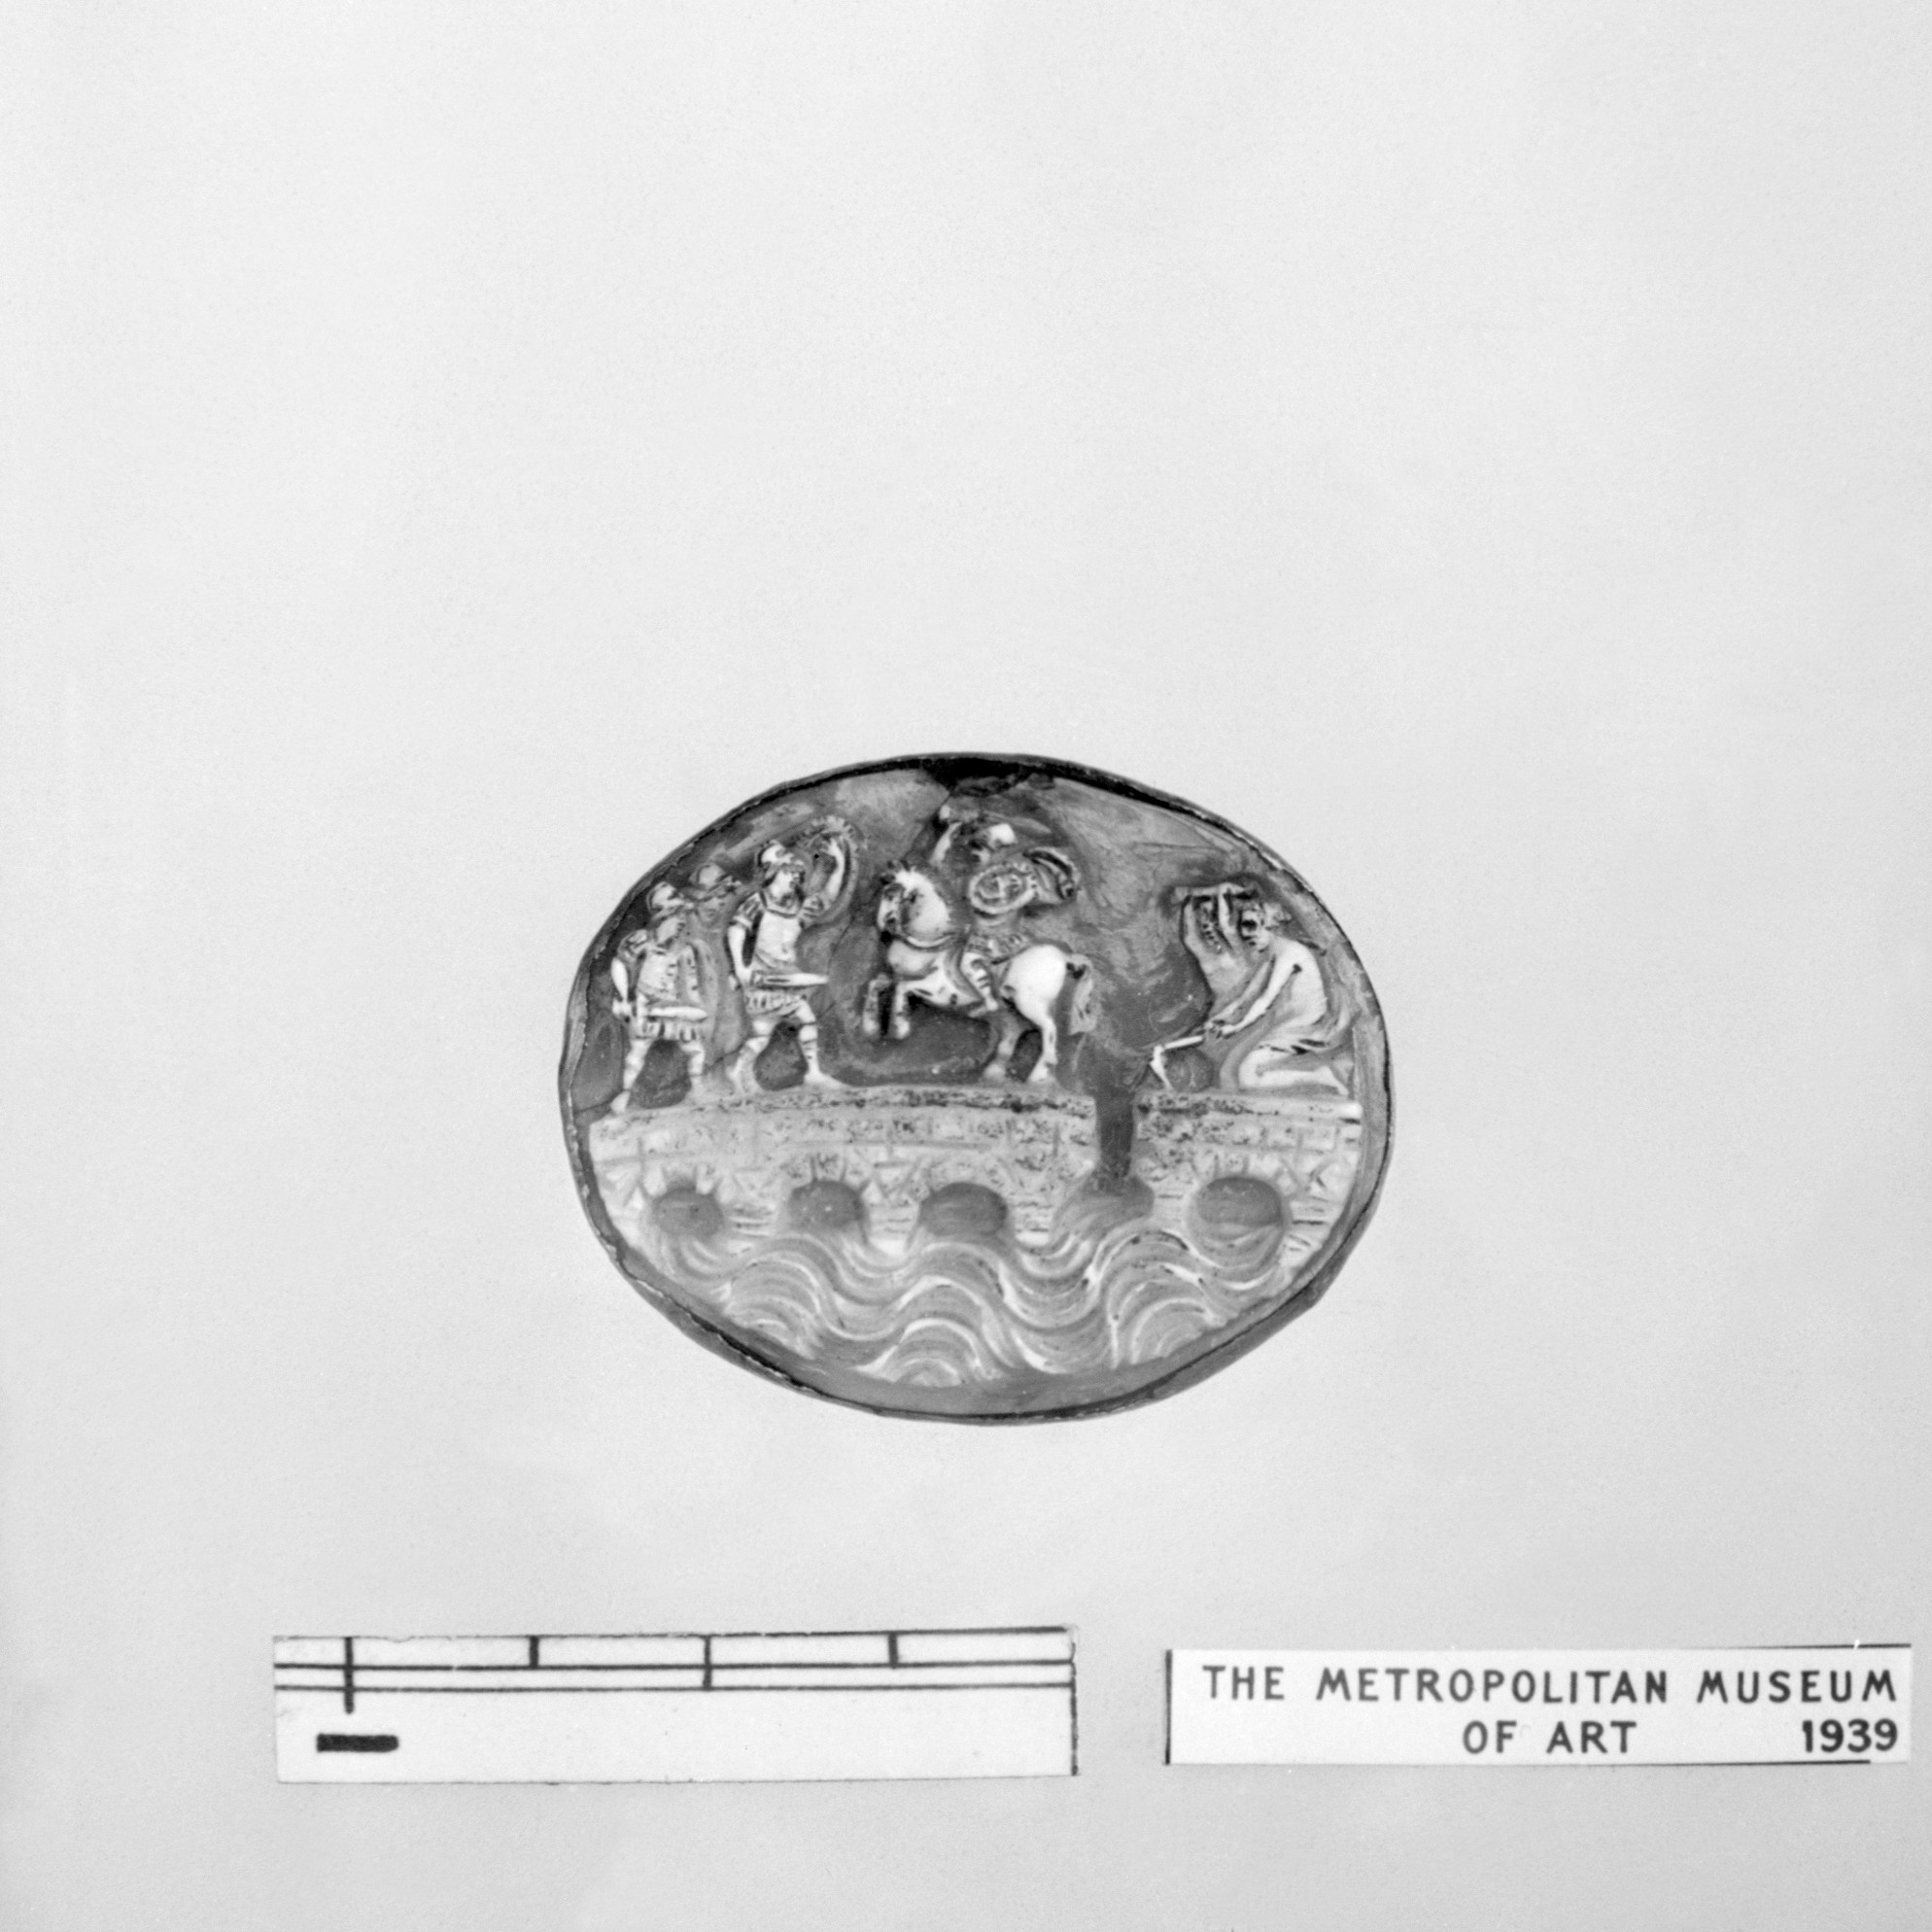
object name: cameo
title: Horatius at the Bridge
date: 1567-1600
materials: gold, onyx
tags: men,horses